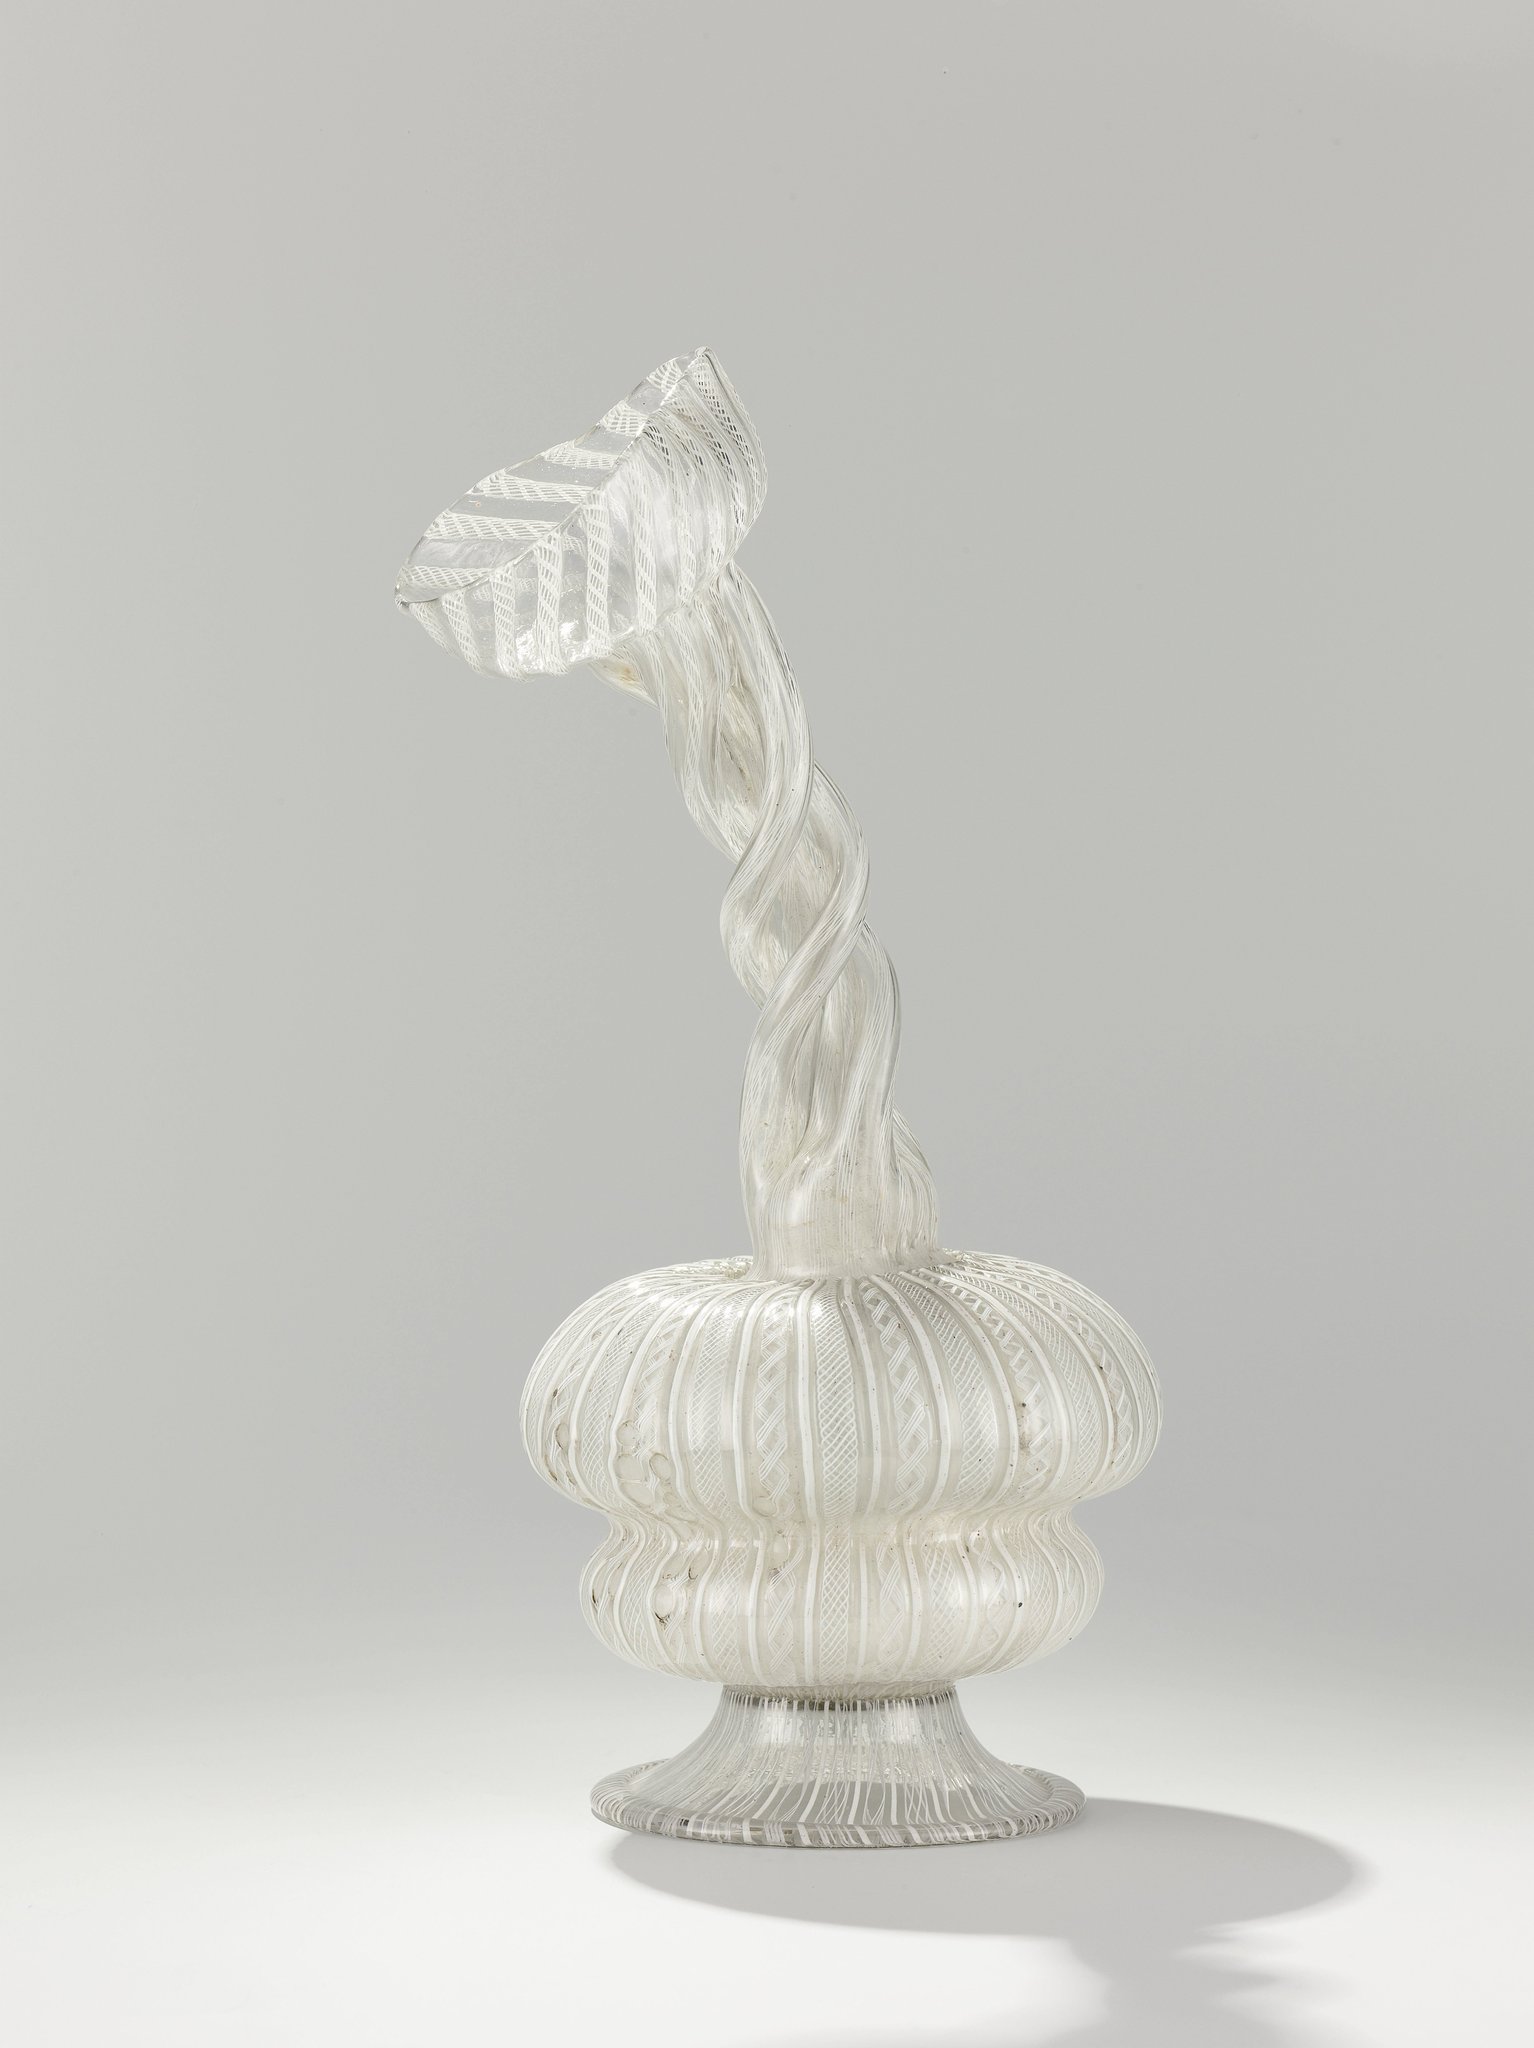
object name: kuttrolf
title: Kuttrolf van filigraanglas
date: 1600-1700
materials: glass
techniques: façon de venise, glassblowing, vetro a retorti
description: Kuttrolf, filigree glass. Venice or façon de Venise, c. 1600-1700.